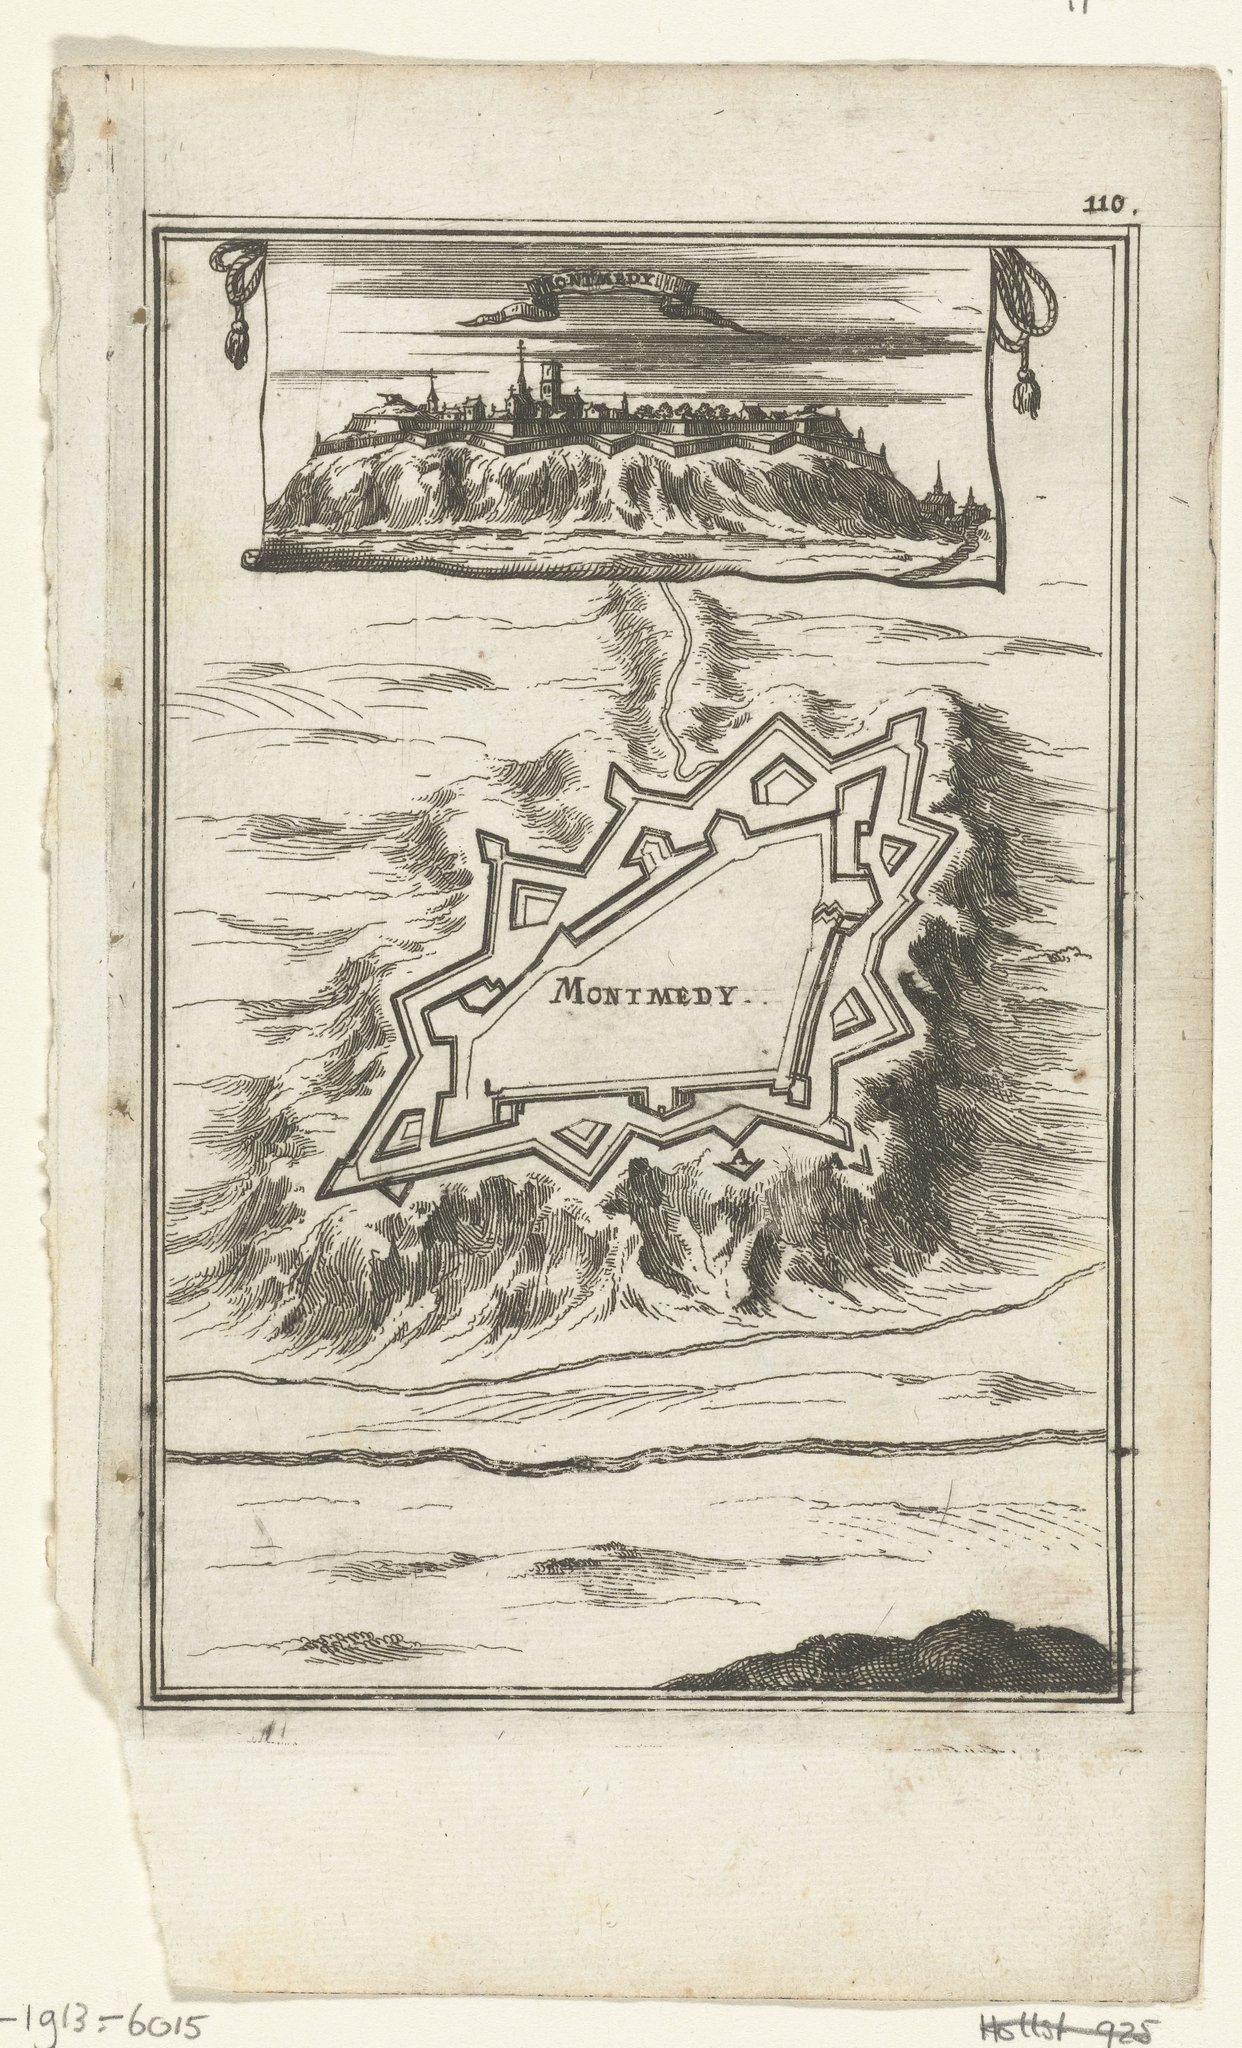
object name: book illustration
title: Illustratie voor 'Den Arbeid van Mars' van Allain Manesson Mallet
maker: romeyn de hooghe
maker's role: draughtsman, goldsmith, painter, print maker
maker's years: 1645-1708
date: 1672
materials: paper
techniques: engraving, etching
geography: amsterdam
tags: fortifications, military engineering, prospect of city, town panorama, silhouette of city, mountains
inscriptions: collector's mark: Lugt 2228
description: Grondplan van een vesting op een berg (Montmédy). Daarboven, als op een doek of stuk papier, een gezicht op de betreffende stad. In de hoek rechtsboven het cijfer 110 (= het nummer van de pagina in het boek waartegenover de illustratie geplaatst is).